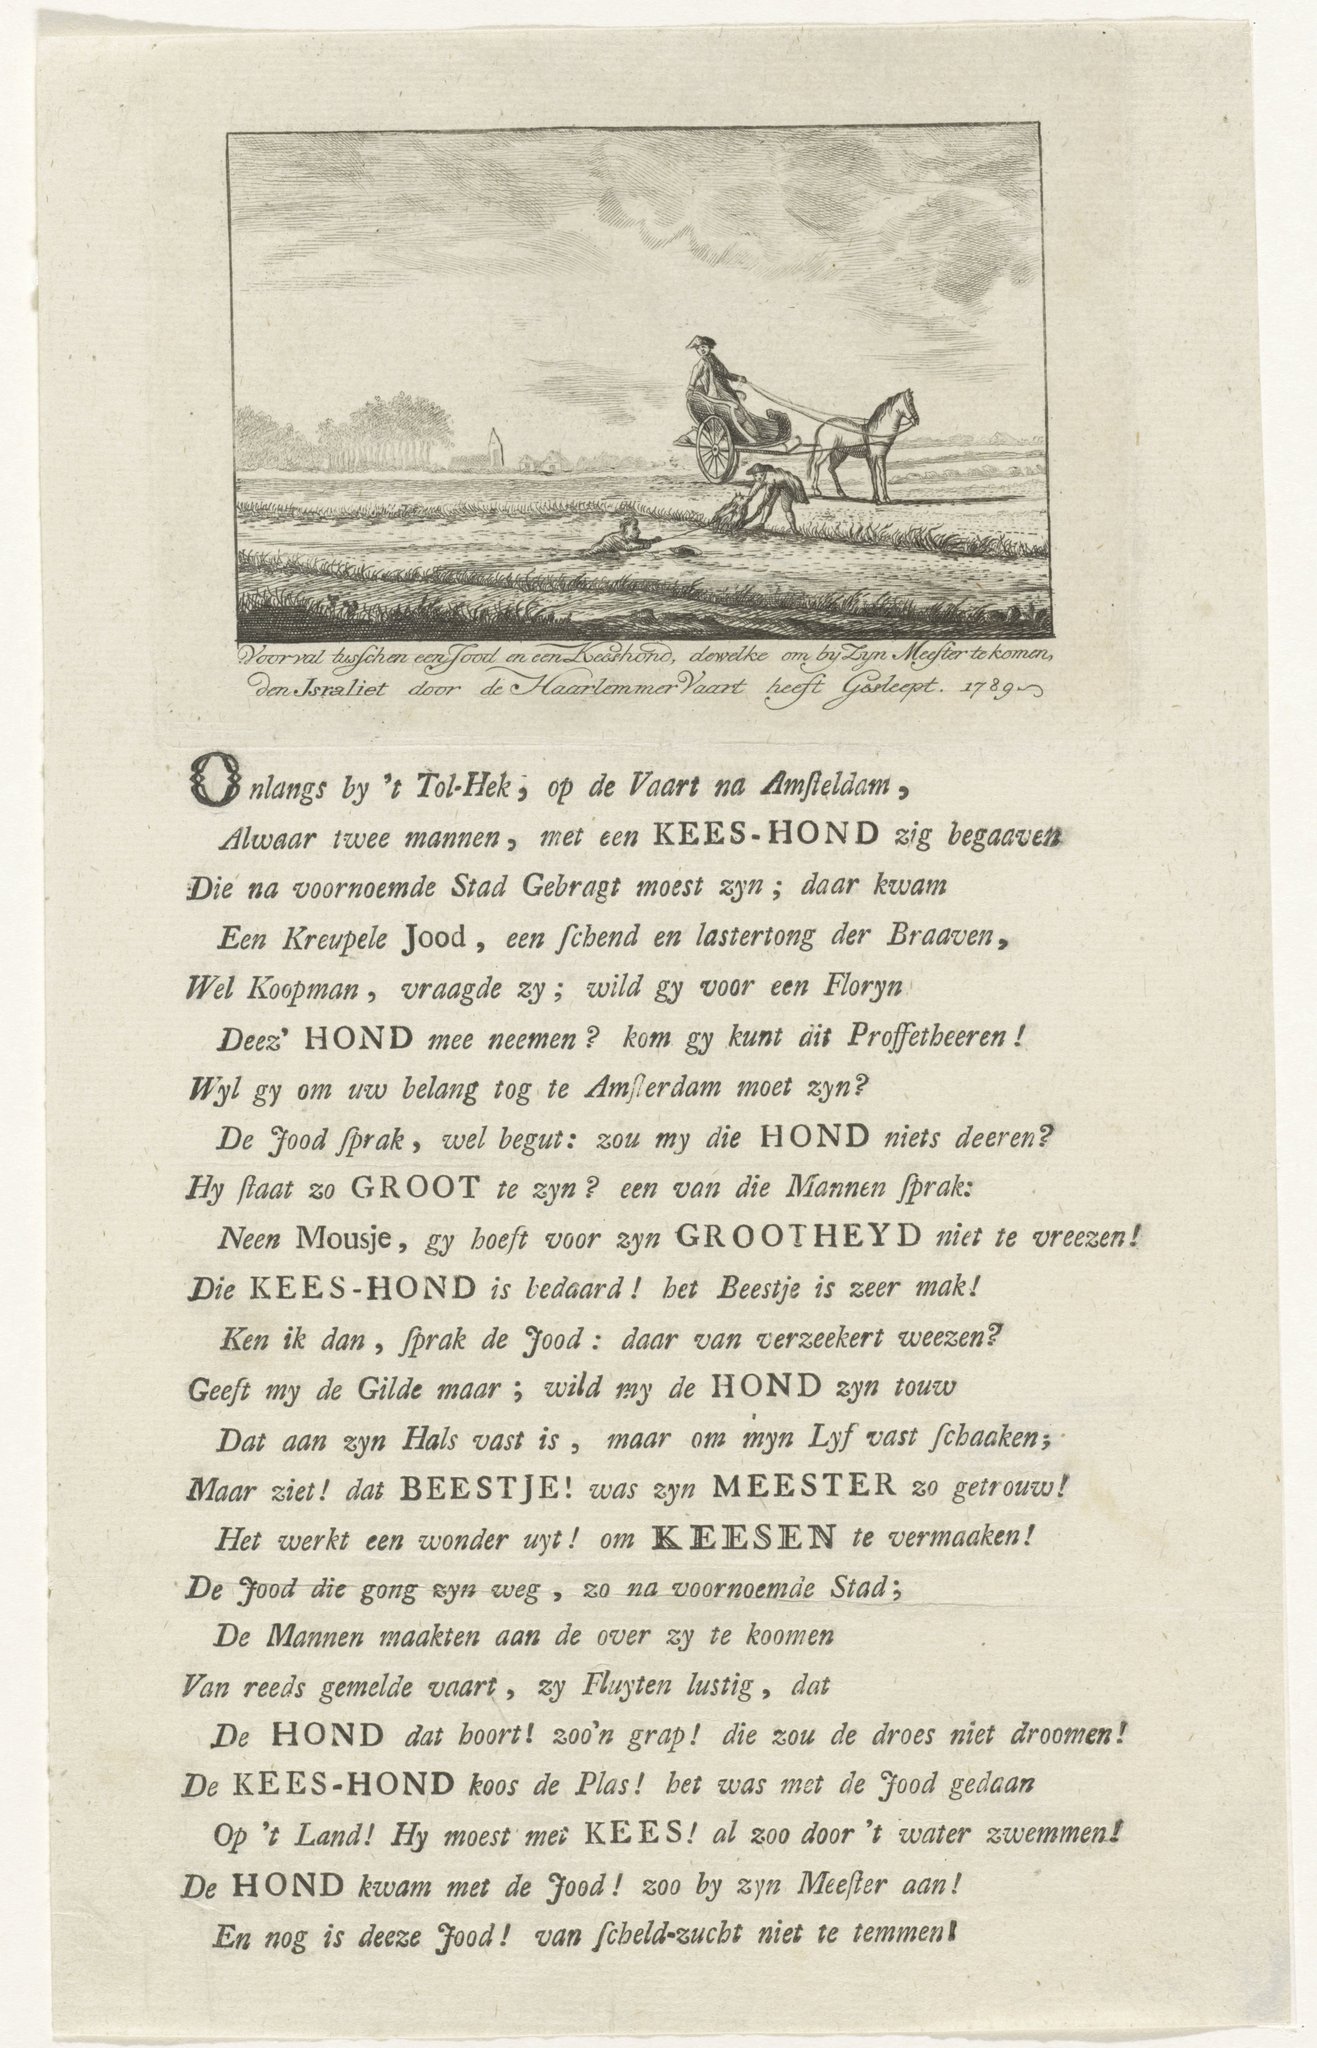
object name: print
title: Voorval tusschen een Jood en een Keeshond, dewelke om by Zyn Meester te komen, den Israliet door de Haarlemmer Vaart heeft Gesleept. 1789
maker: Anonymous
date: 1789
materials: paper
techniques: engraving, etching, letterpress printing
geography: northern netherlands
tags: anti-semitism, patriots (1780-1795)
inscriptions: collector's mark: Lugt 2228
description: Landschap met een rijtuig bij de Haarlemmertrekvaart. Een keeshond sleept een jood, aan wie de hond was verkocht, door het water naar de overkant terug naar zijn voormalig baasje. Het - fictieve? - voorval moet waarschijnlijk als een politieke analogie geïnterpreteerd worden. Op het blad onder de plaat een vers van 24 regels.